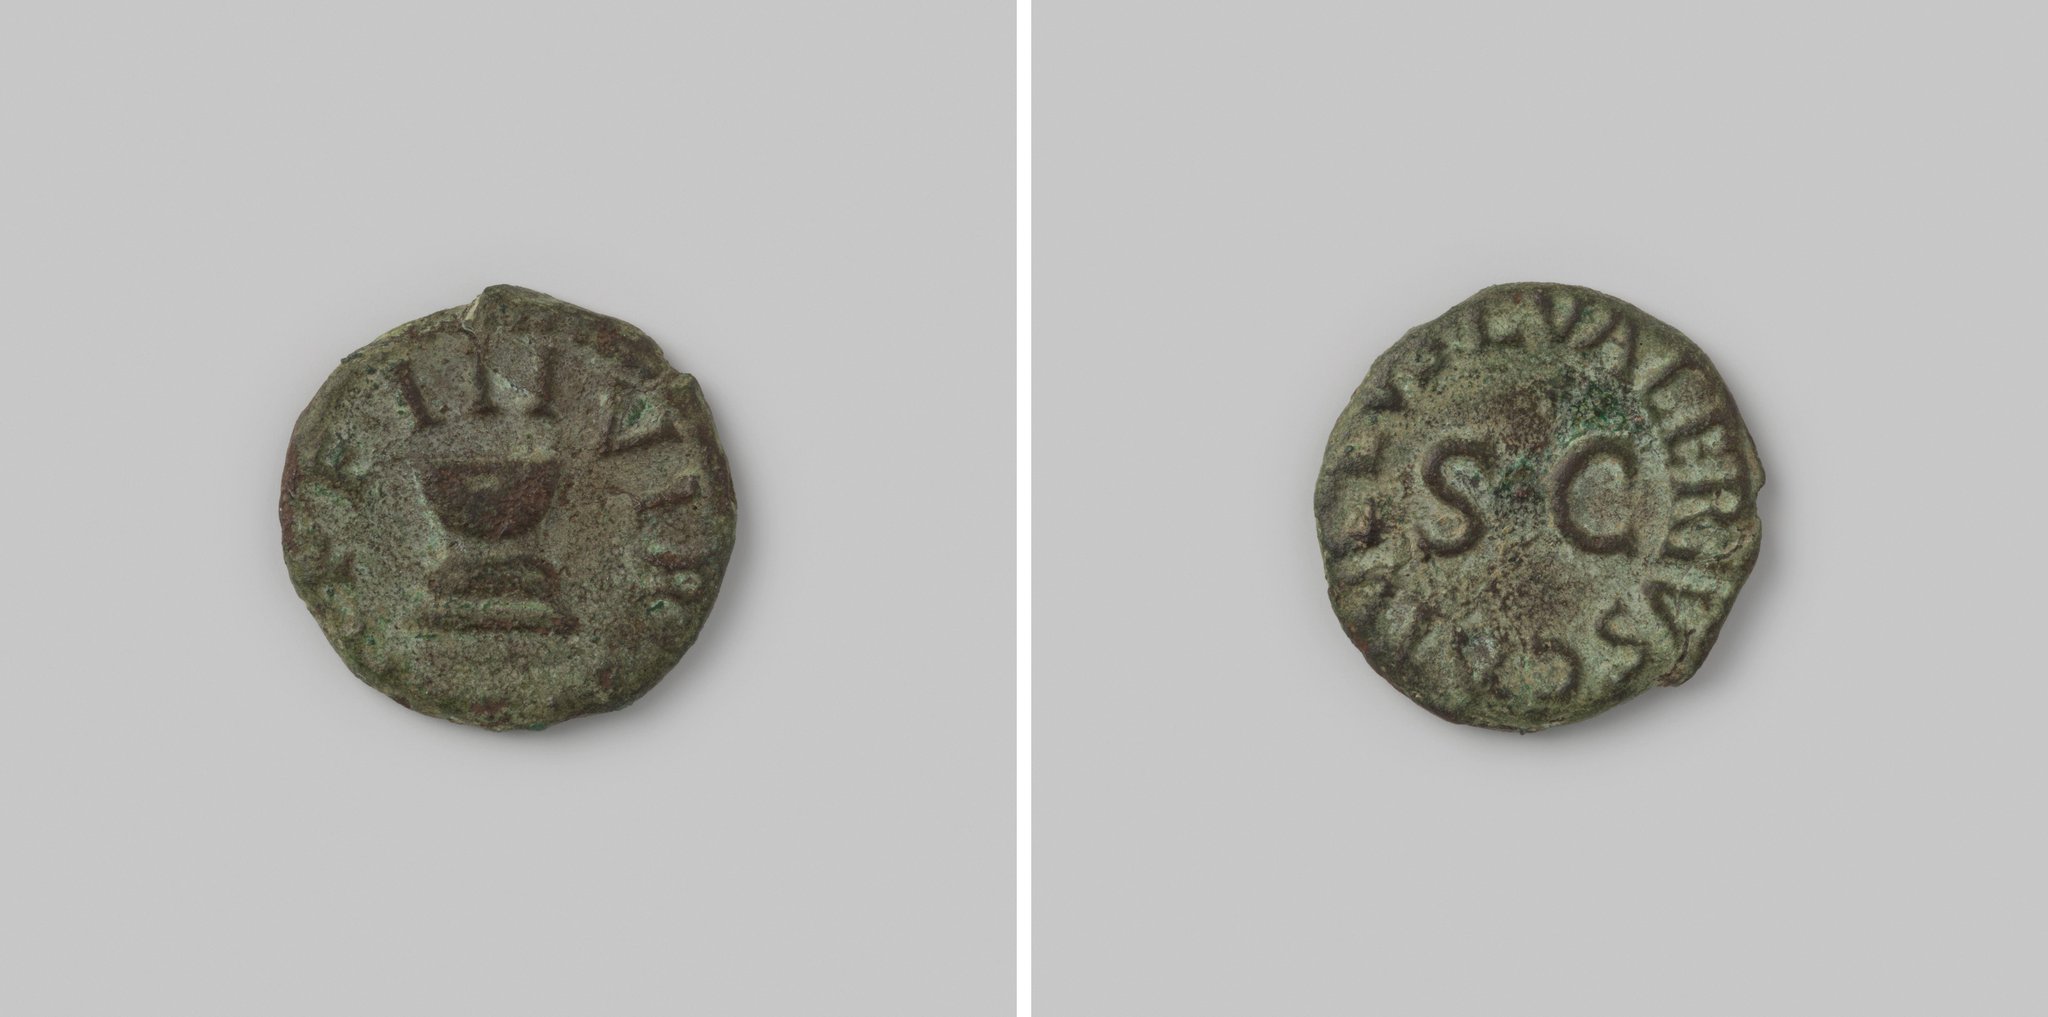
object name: quadrans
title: Quadrans uit het Romeinse Keizerrijk van Augustus, -4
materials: bronze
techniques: striking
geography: rome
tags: rome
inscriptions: circumscription, circumscription: ‘L VALERIVS CATVLLVS’, inscription: ‘SC’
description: Bronzen quadrans. Voorzijde: aambeeld. Keerzijde: in het veld de letters S en C. In het omschrift de naam van Lucius Valerius Catullus, monetarius.